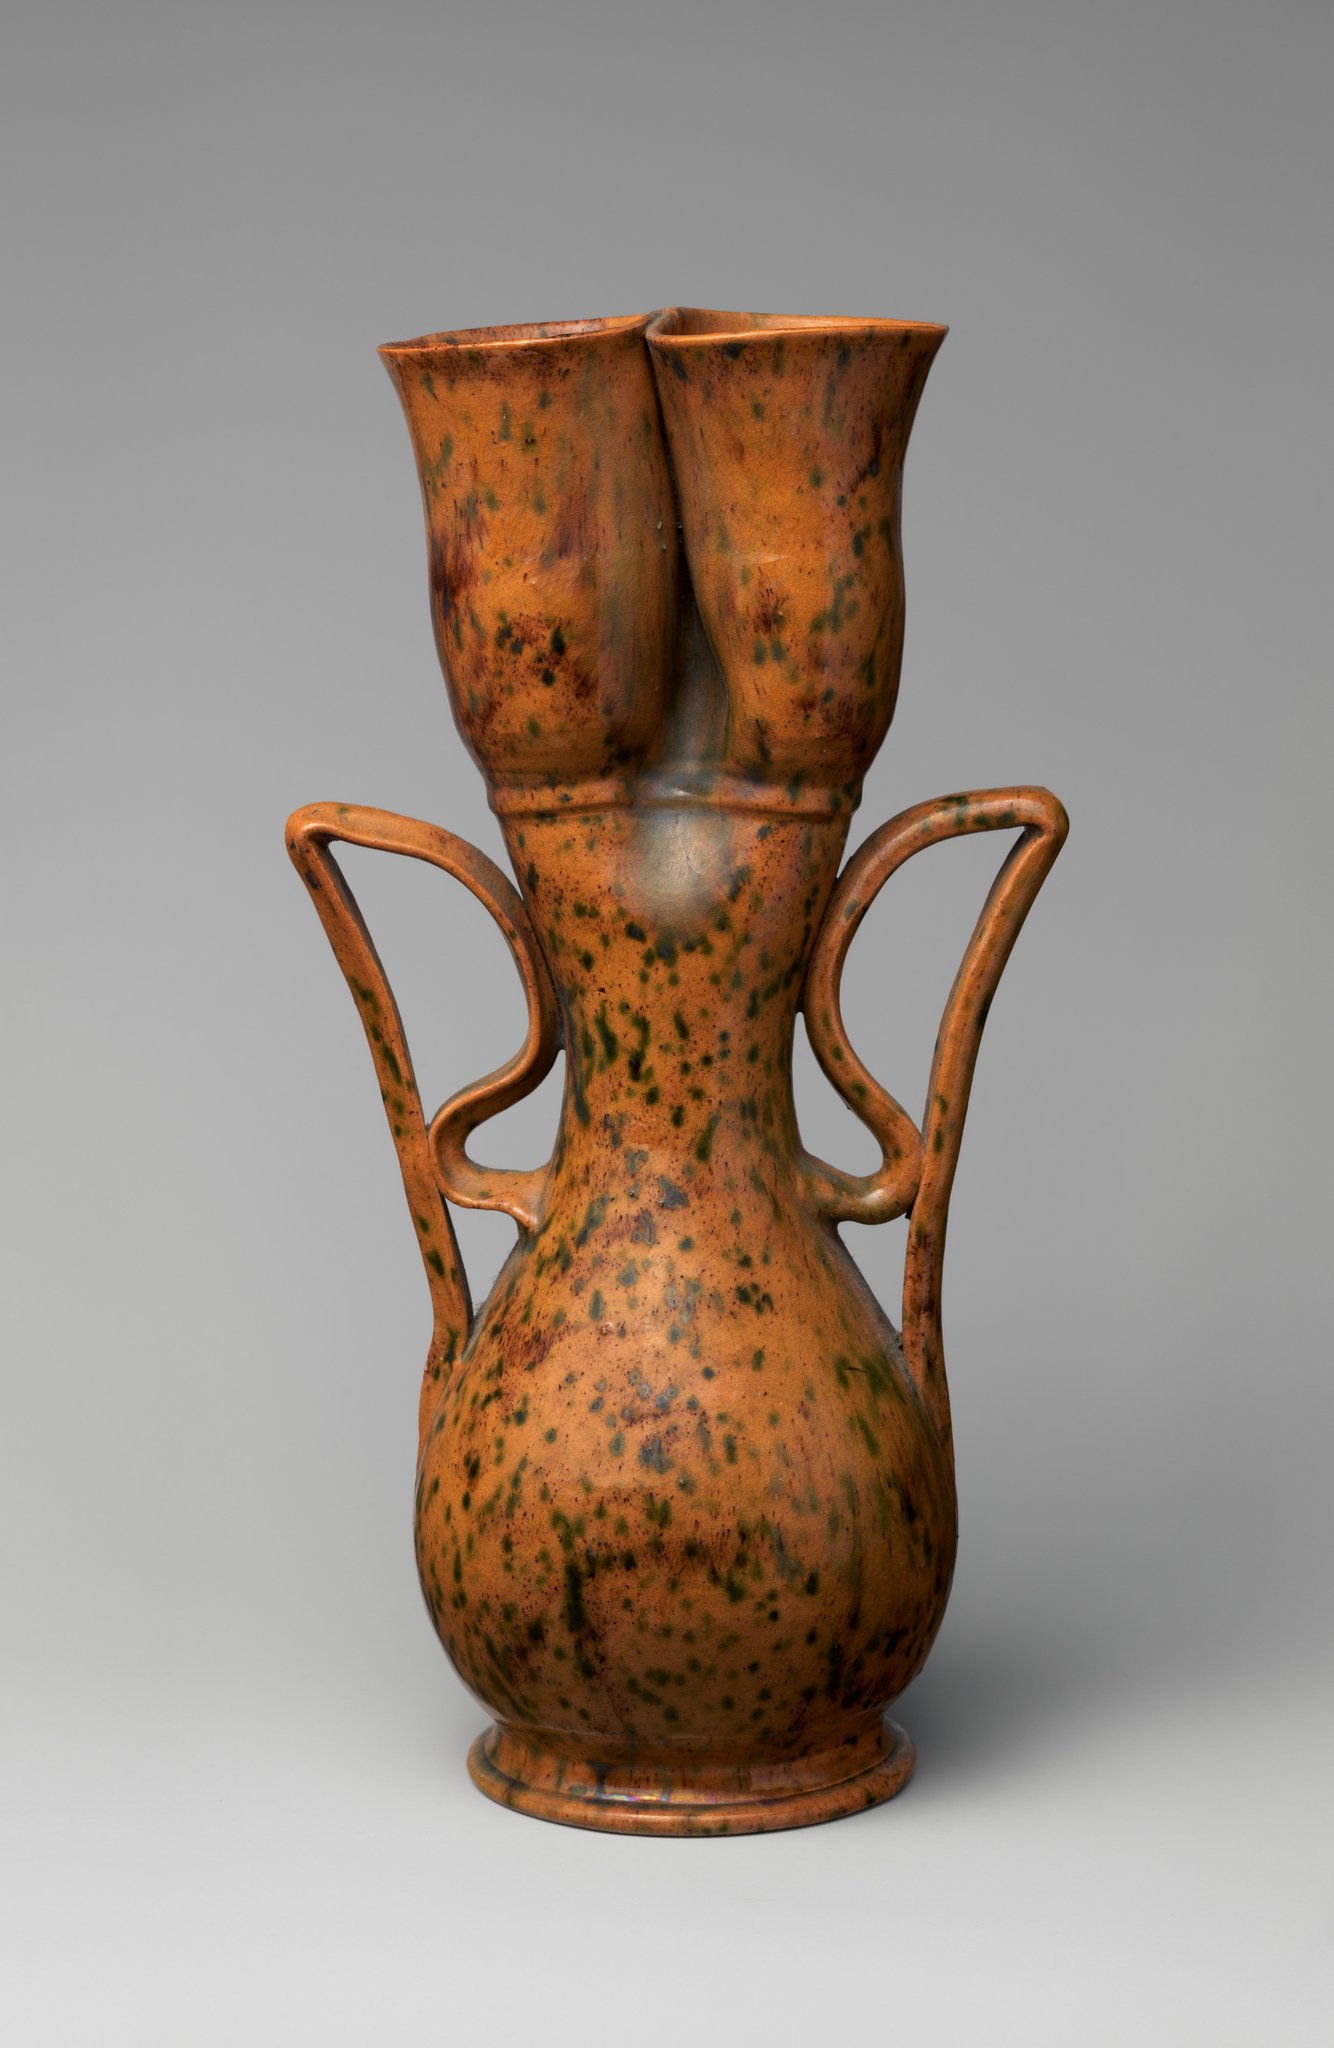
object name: vase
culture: american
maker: george e. ohr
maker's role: maker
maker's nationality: american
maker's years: 1857-1918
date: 1897-1900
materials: earthenware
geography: united states